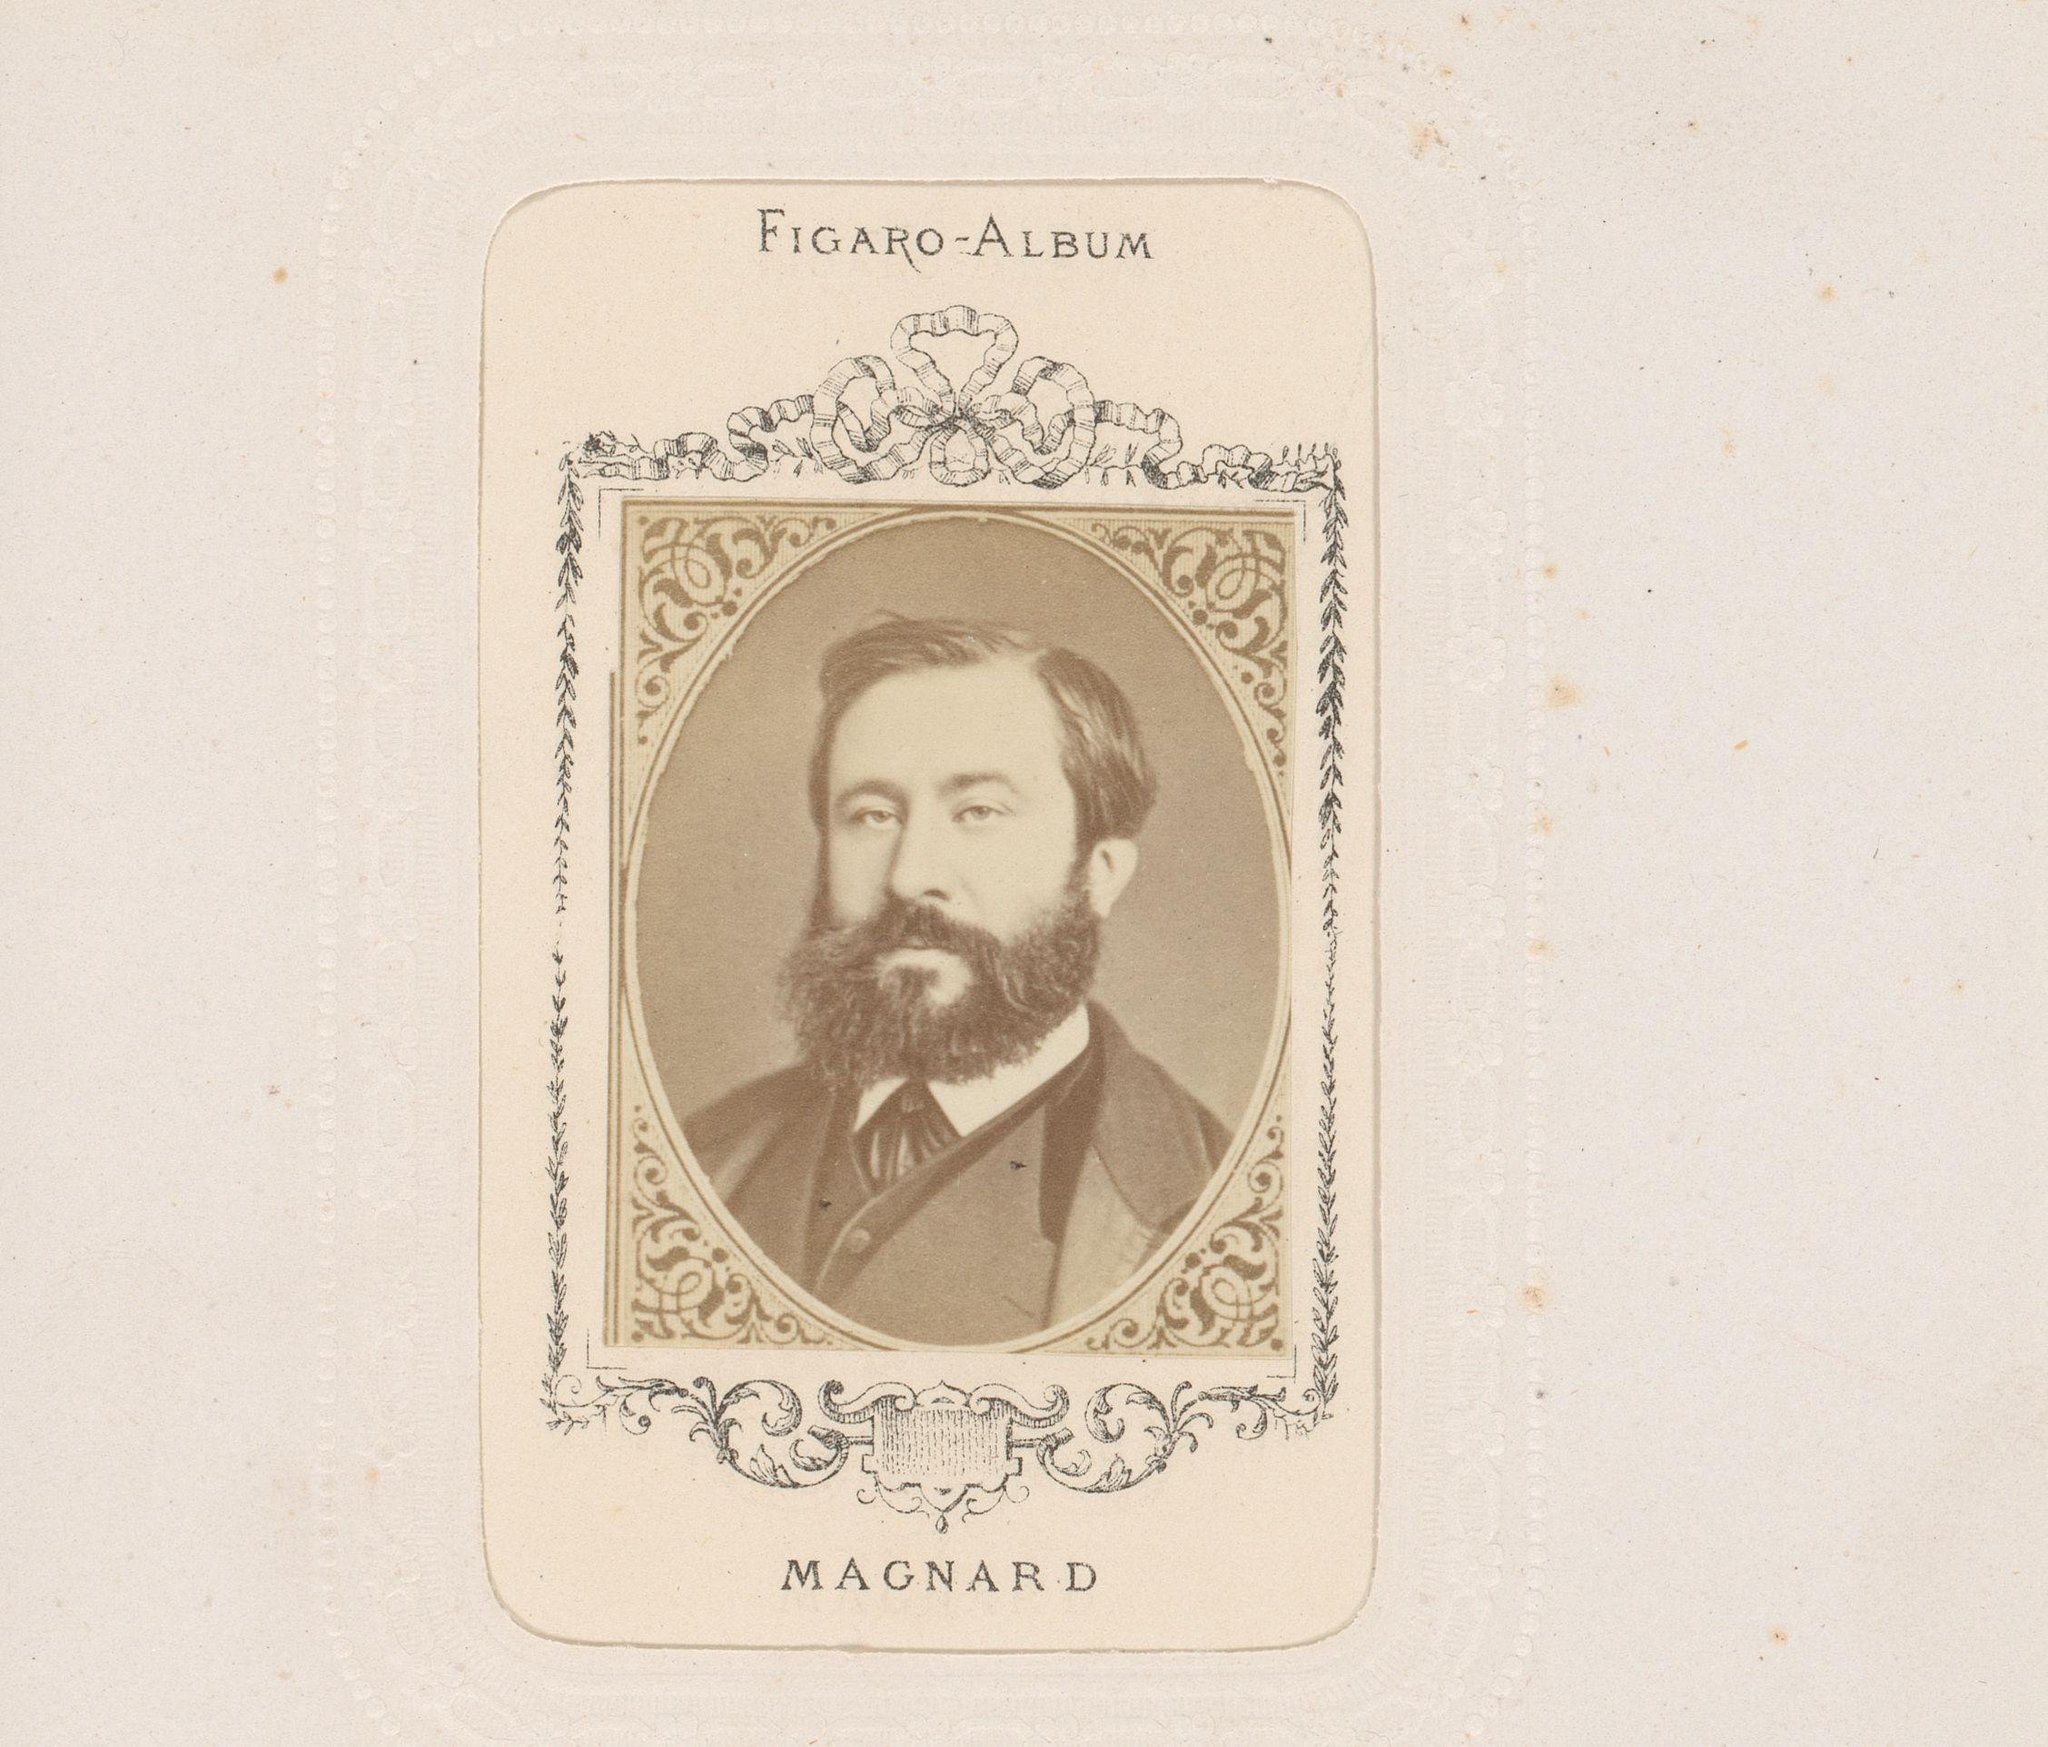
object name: photograph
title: Fotoreproductie van een portret van Francis Magnard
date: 1860-1900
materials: cardboard, photographic support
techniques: albumen print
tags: journalist, reporter, historical persons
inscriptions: inscription: ‘Figaro-Album/ Magnard/ Liébert Phot.’